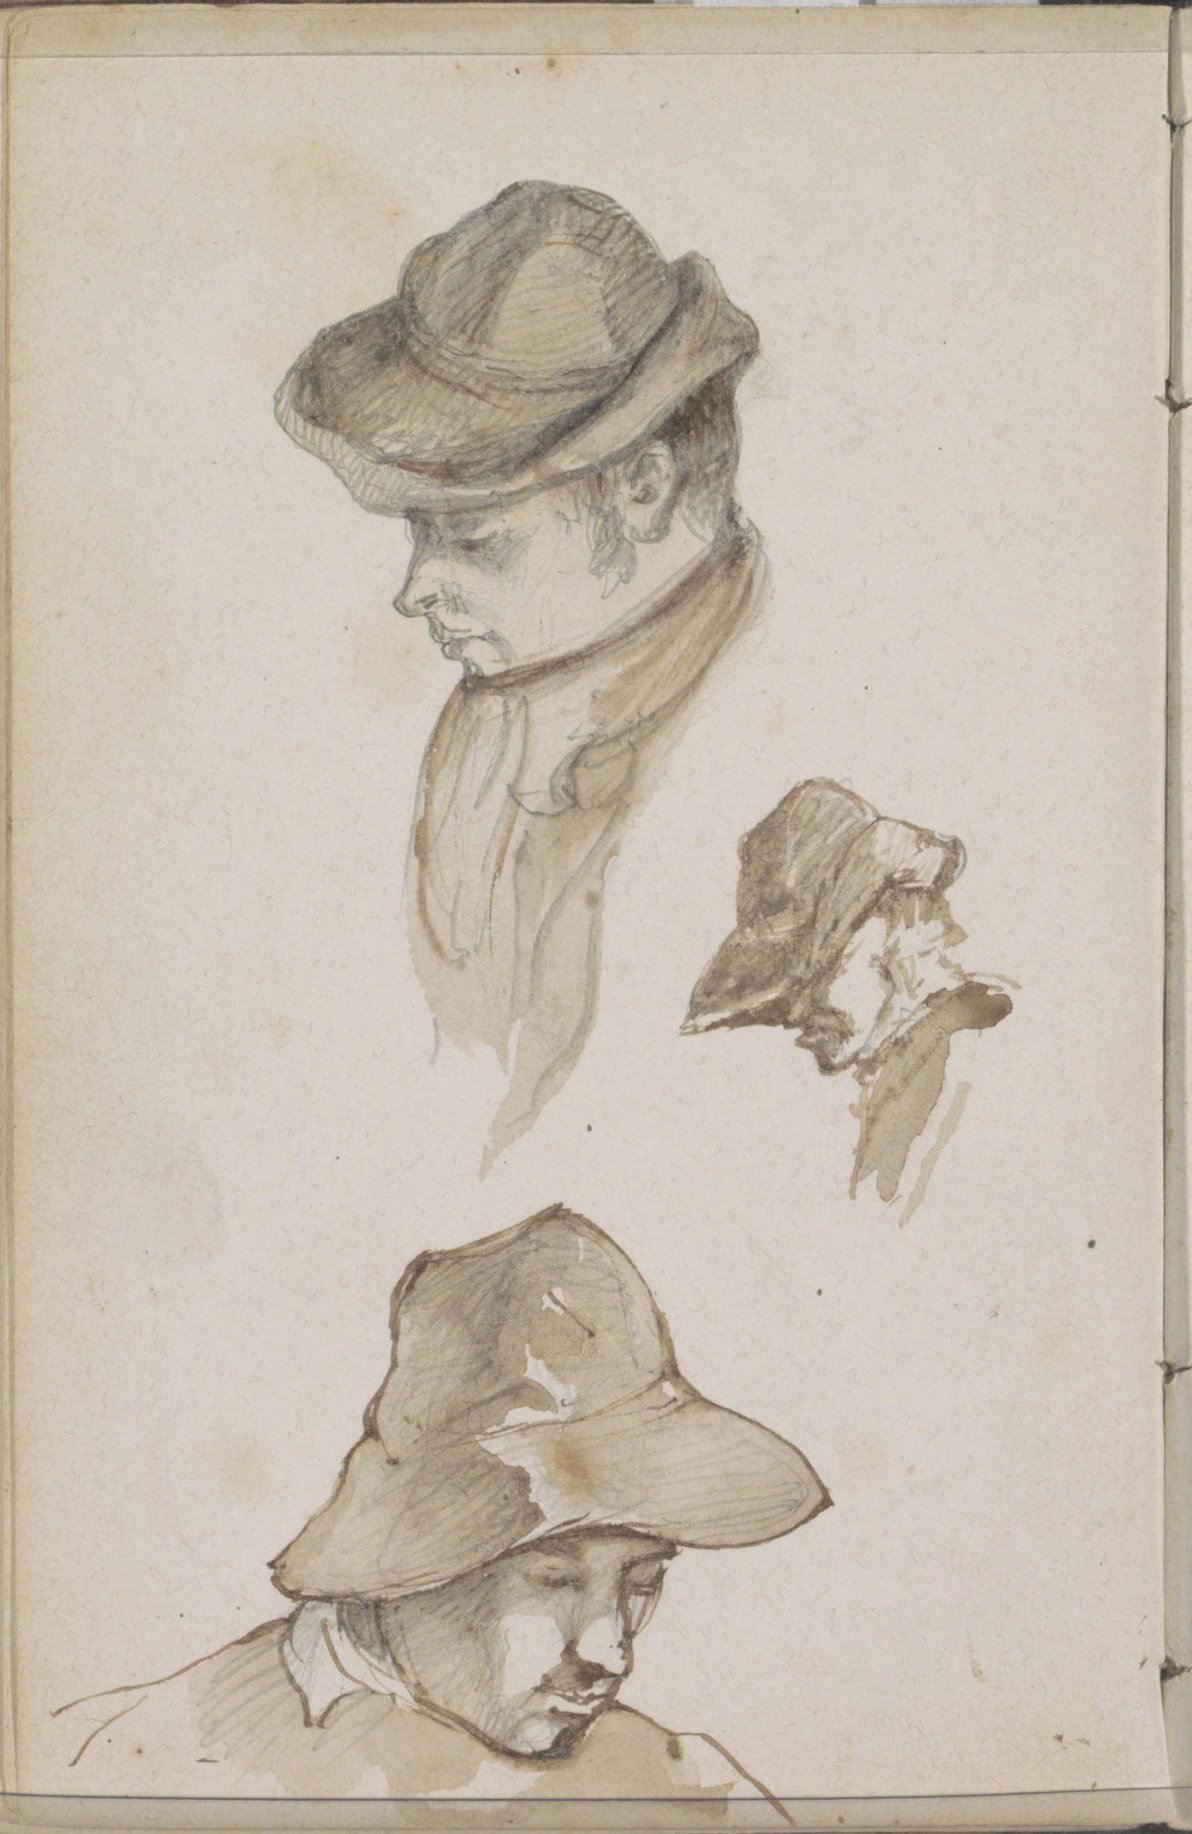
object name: sketchbook leaf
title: Drie mannenkoppen met hoeden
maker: johannes tavenraat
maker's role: draughtsman, painter, print maker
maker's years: 1809-1881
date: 1811-1862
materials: ink, paper, pencil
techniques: brush, pen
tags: head (human), adult man, head-gear: hat (+ men's clothes)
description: Blad 35 verso uit een schetsboek met 65 bladen.